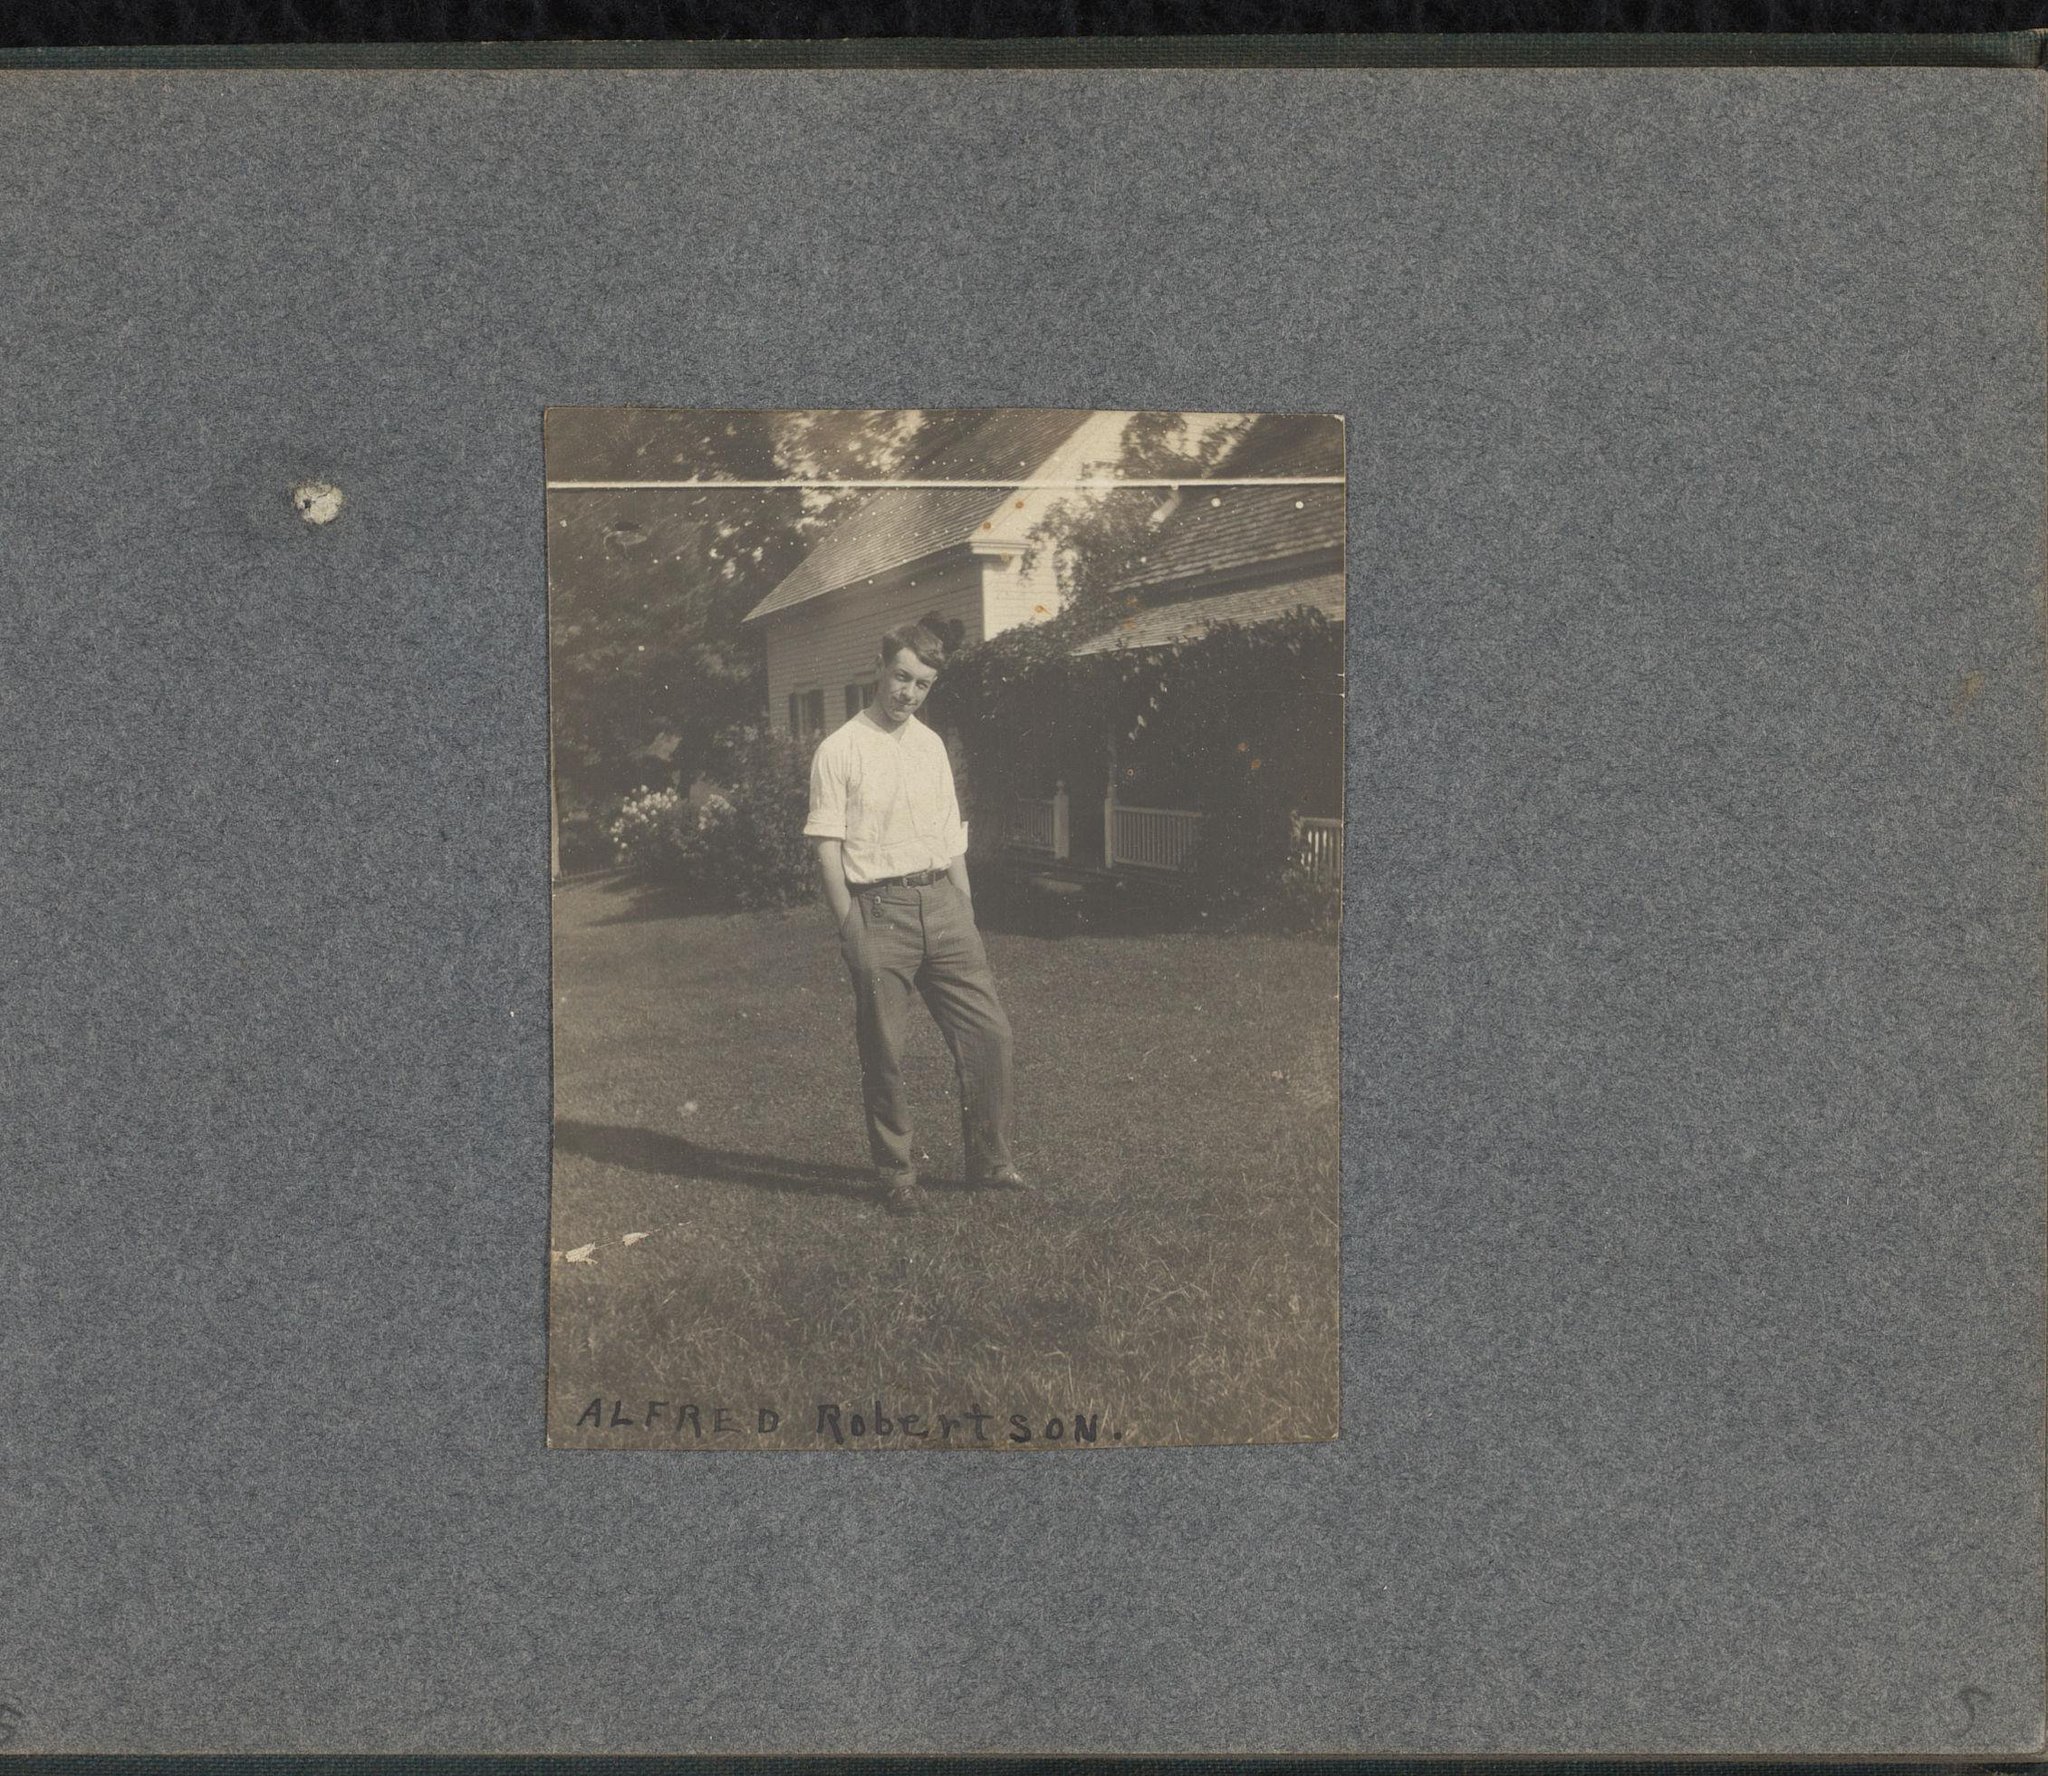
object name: album leaf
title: Portret van Alfred Robertson in een tuin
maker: Anonymous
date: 1910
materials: paper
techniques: gelatin silver print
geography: united states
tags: garden, historical persons not known by name